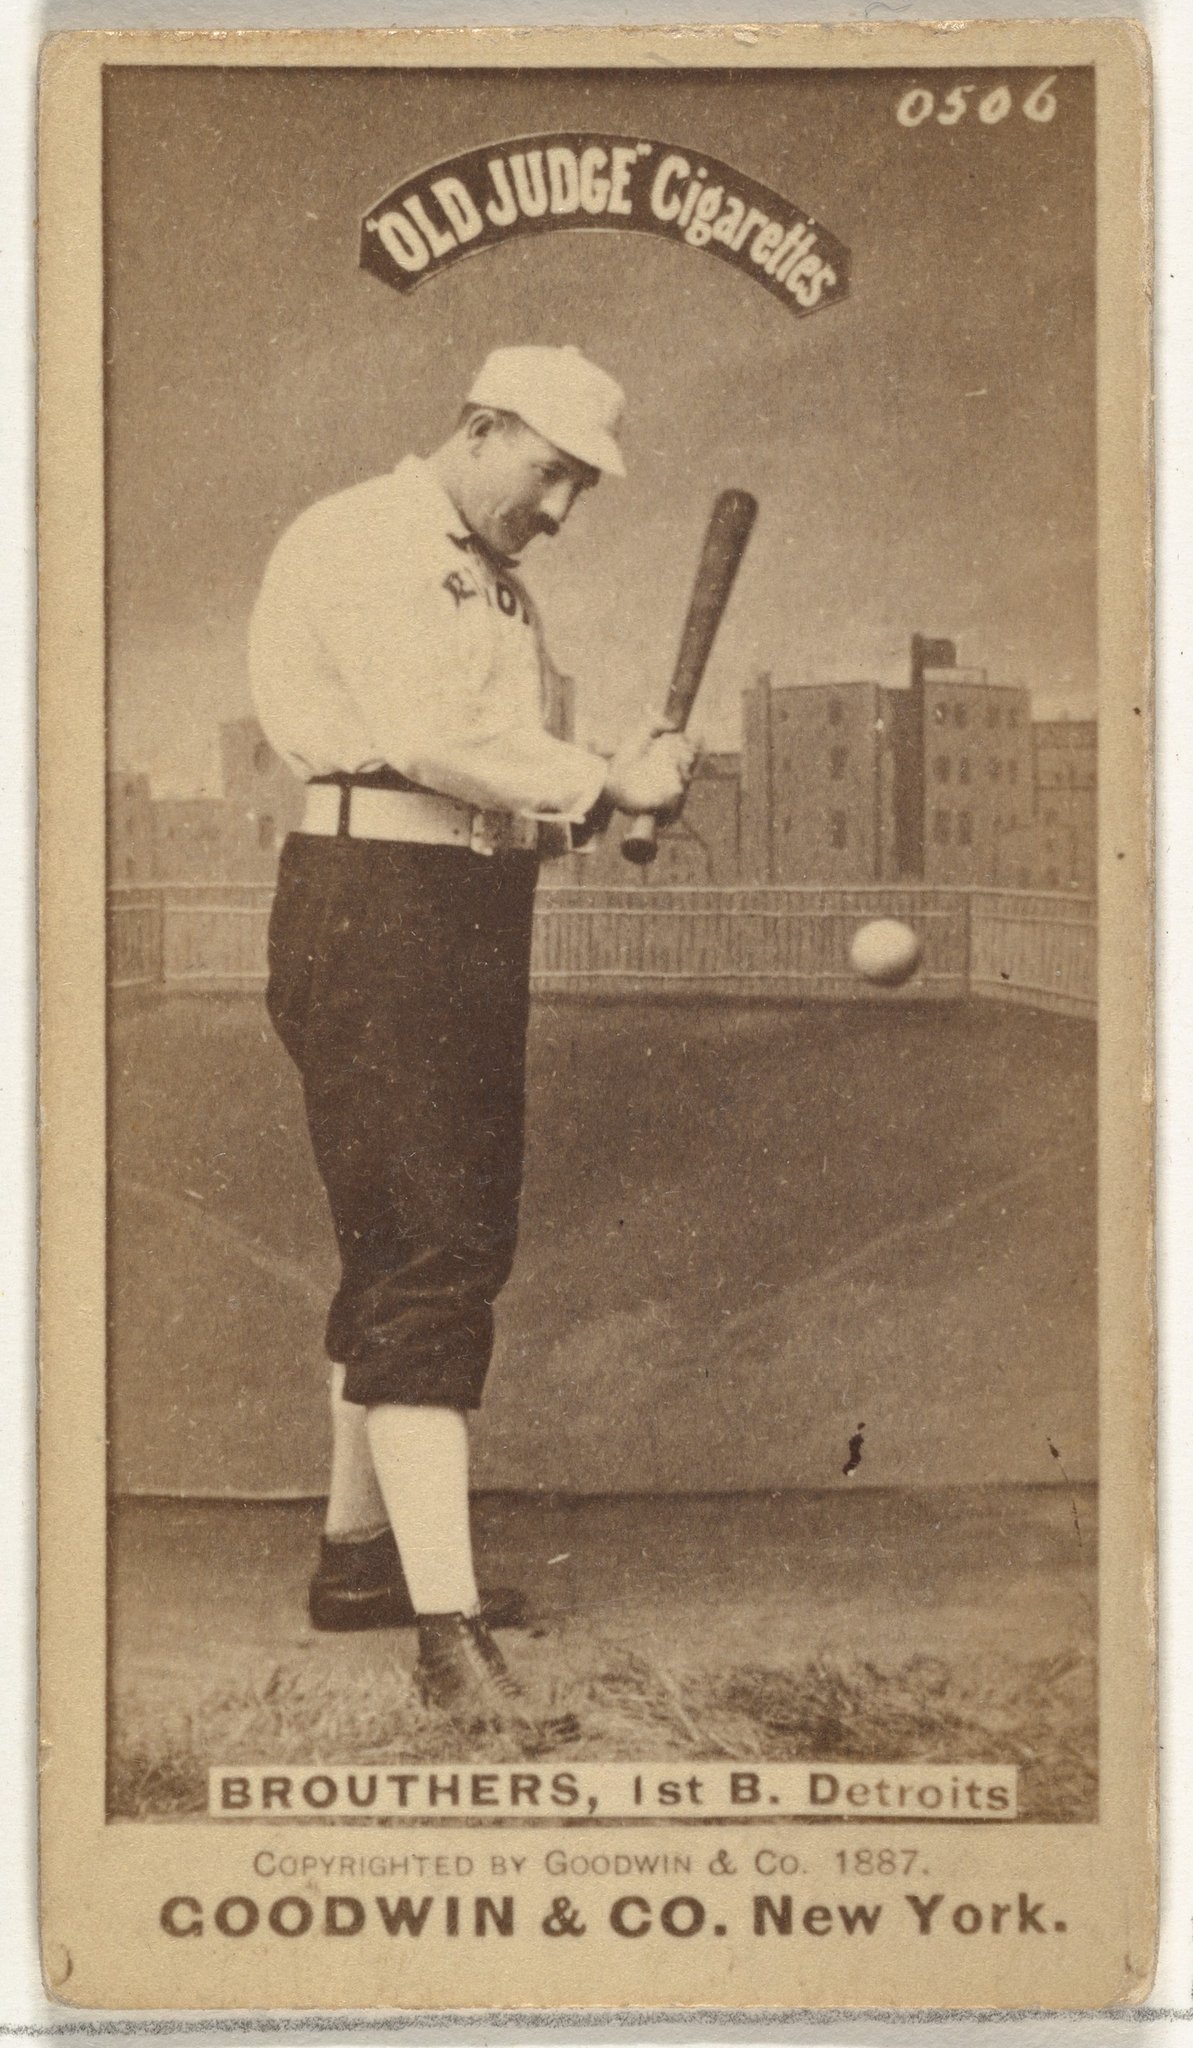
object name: baseball card, photograph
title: Dennis Joseph "Dan" Brouthers, 1st Base, Detroit Wolverines, from the Old Judge series (N172) for Old Judge Cigarettes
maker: goodwin & company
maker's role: publisher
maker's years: 1850-1950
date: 1887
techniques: albumen silver print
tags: men,portraits,baseball,athletes